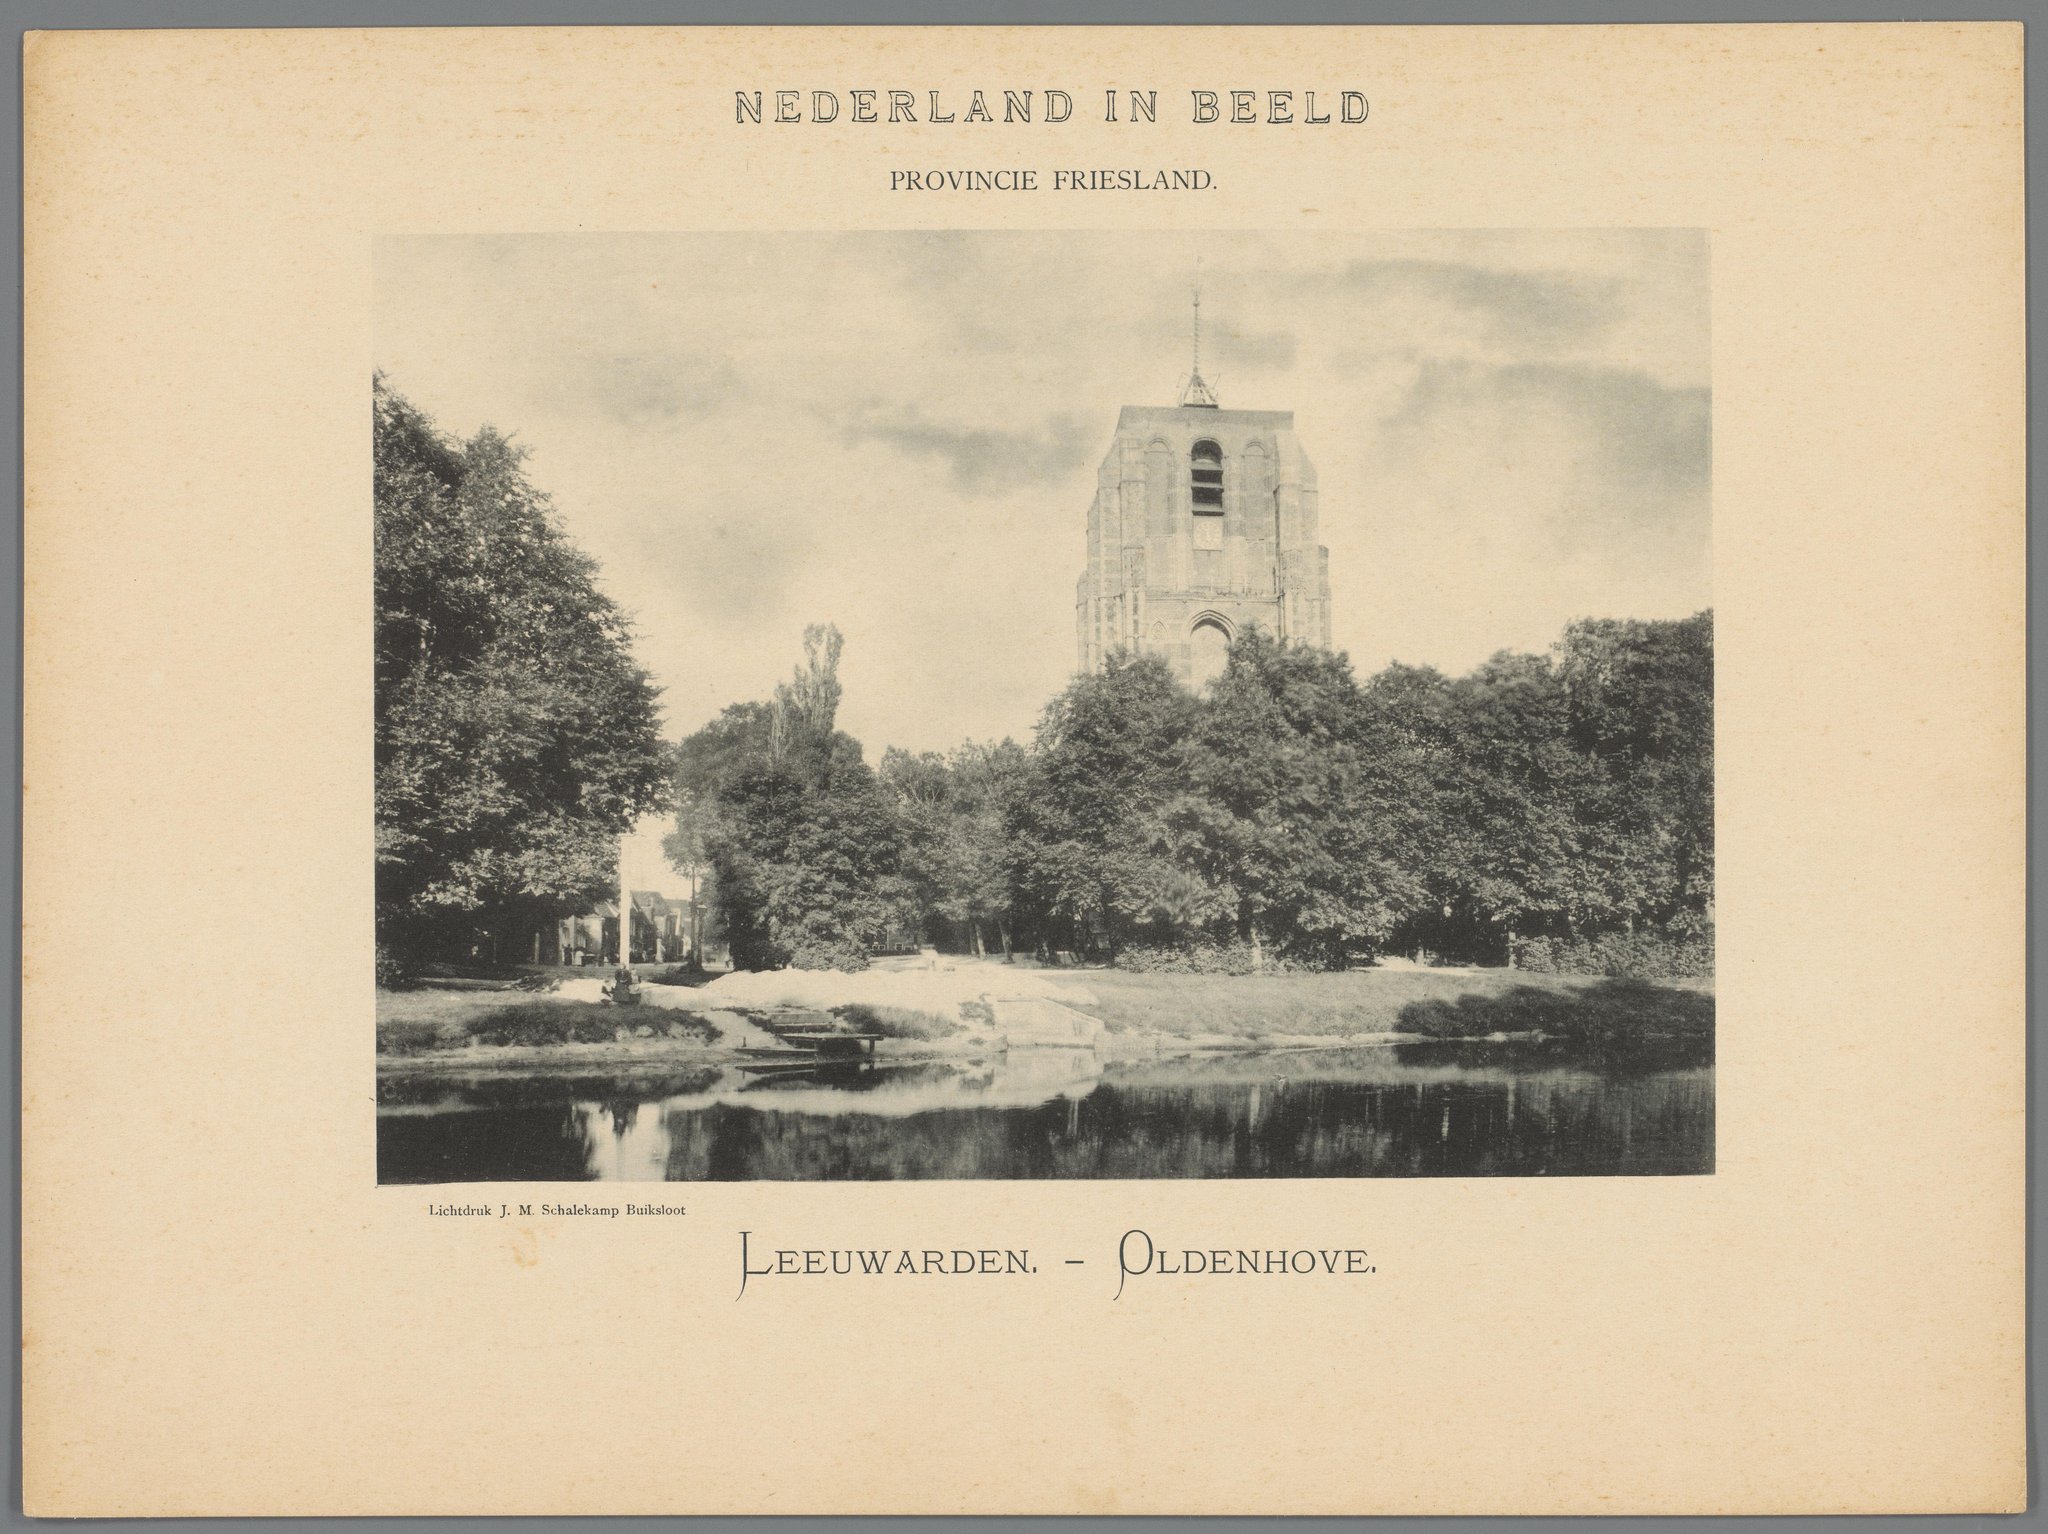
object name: photomechanical print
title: Nederland in beeld. Provincie Friesland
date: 1893-1897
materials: paper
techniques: photograph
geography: leeuwarden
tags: tower, clock tower ~ monumental adornment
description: Deze prent maakt deel uit van een omslag met 43 lichtdrukken op 43 bladen.